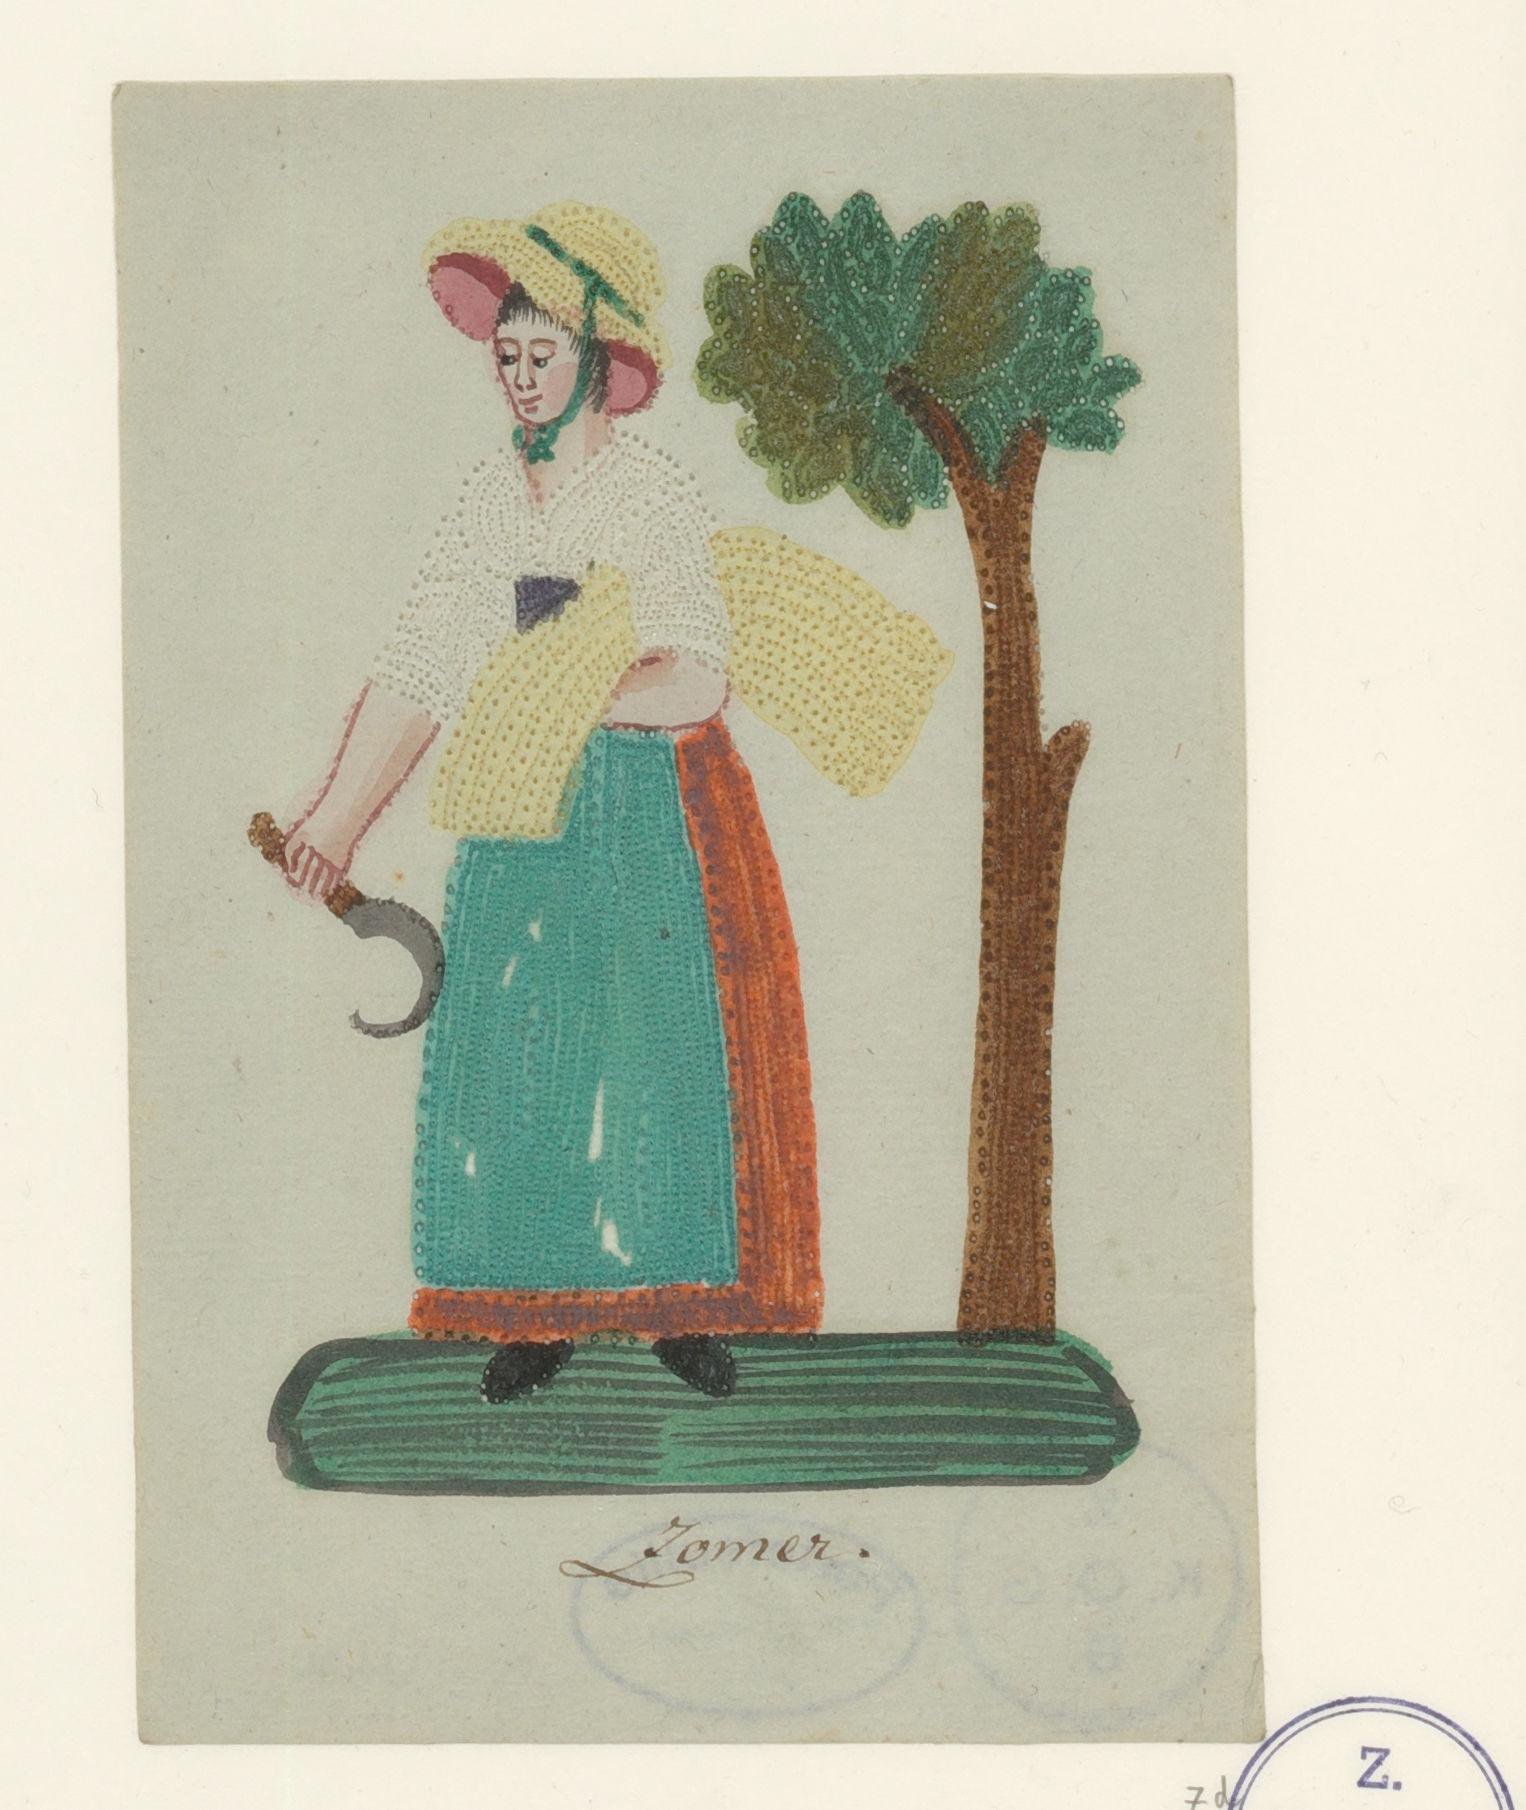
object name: drawing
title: Vrouw met zeis en korenhalm bij een bloeiende boom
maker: Anonymous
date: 1800-1899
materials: gouache, paper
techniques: brush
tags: agricultural implements: scythe, trees, standing figure (canon, proportions) - aa - female human figure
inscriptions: stamp, collector's mark: Lugt 1641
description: Onderwerpsrubrieken binnen de Atlas Zeden en Gewoonten: Schoone kunsten, Diverse liefhebberijen (o.a. prikprenten).